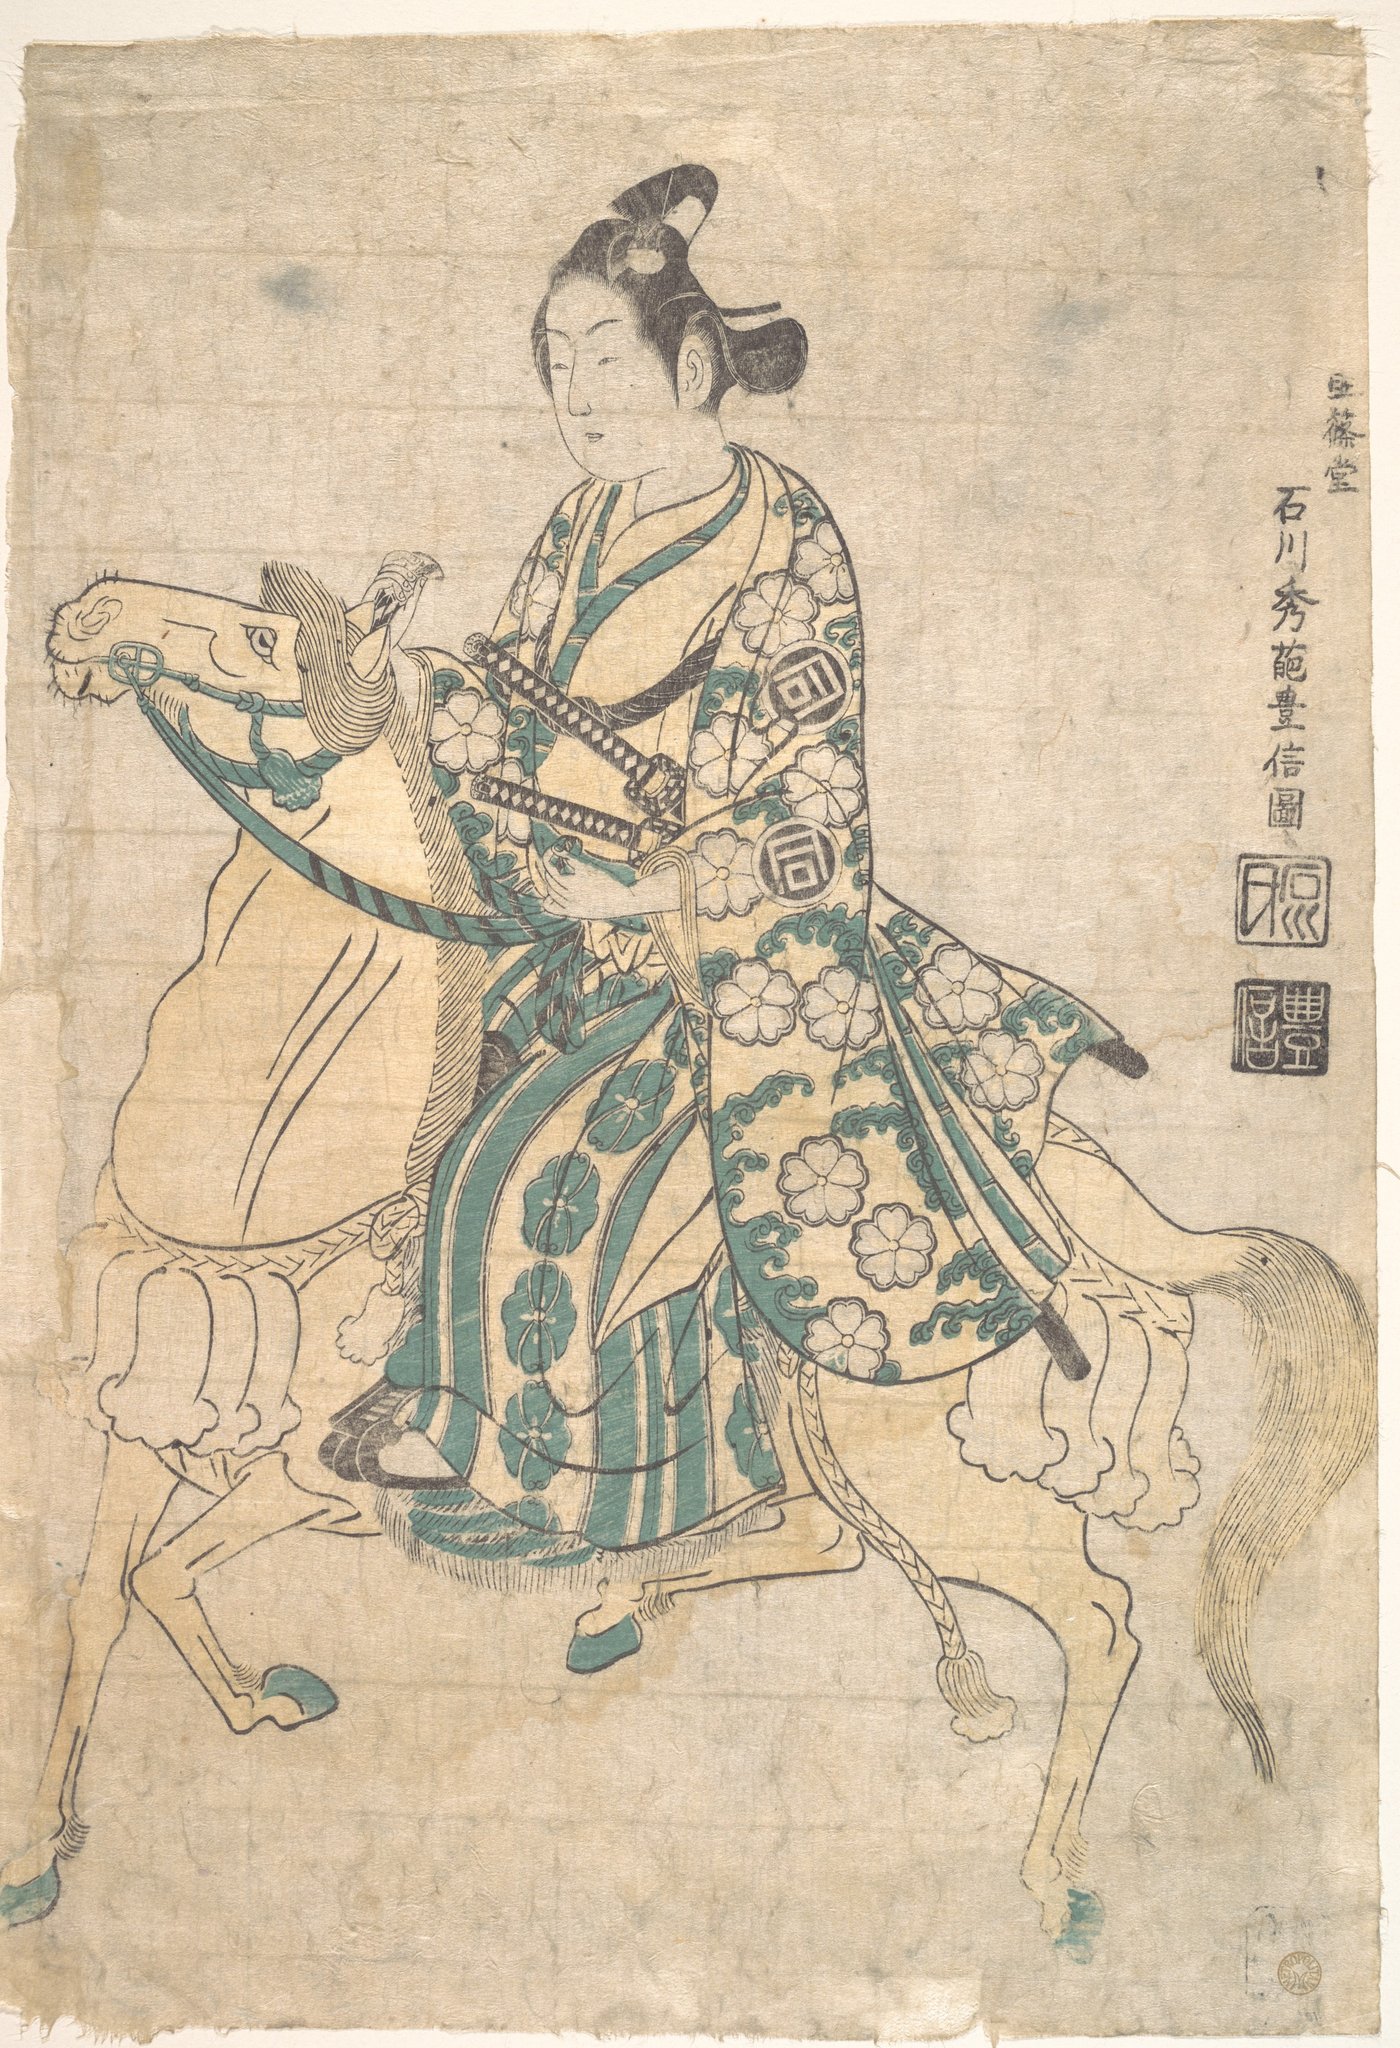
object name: woodblock print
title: Actor Sanokawa Ichimatsu as Young Samurai riding on Horse-back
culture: japanese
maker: ishikawa toyonobu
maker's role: artist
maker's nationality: japanese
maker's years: 1711-1785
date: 1711-1785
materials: ink, paper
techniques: woodblock print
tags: horses,actors